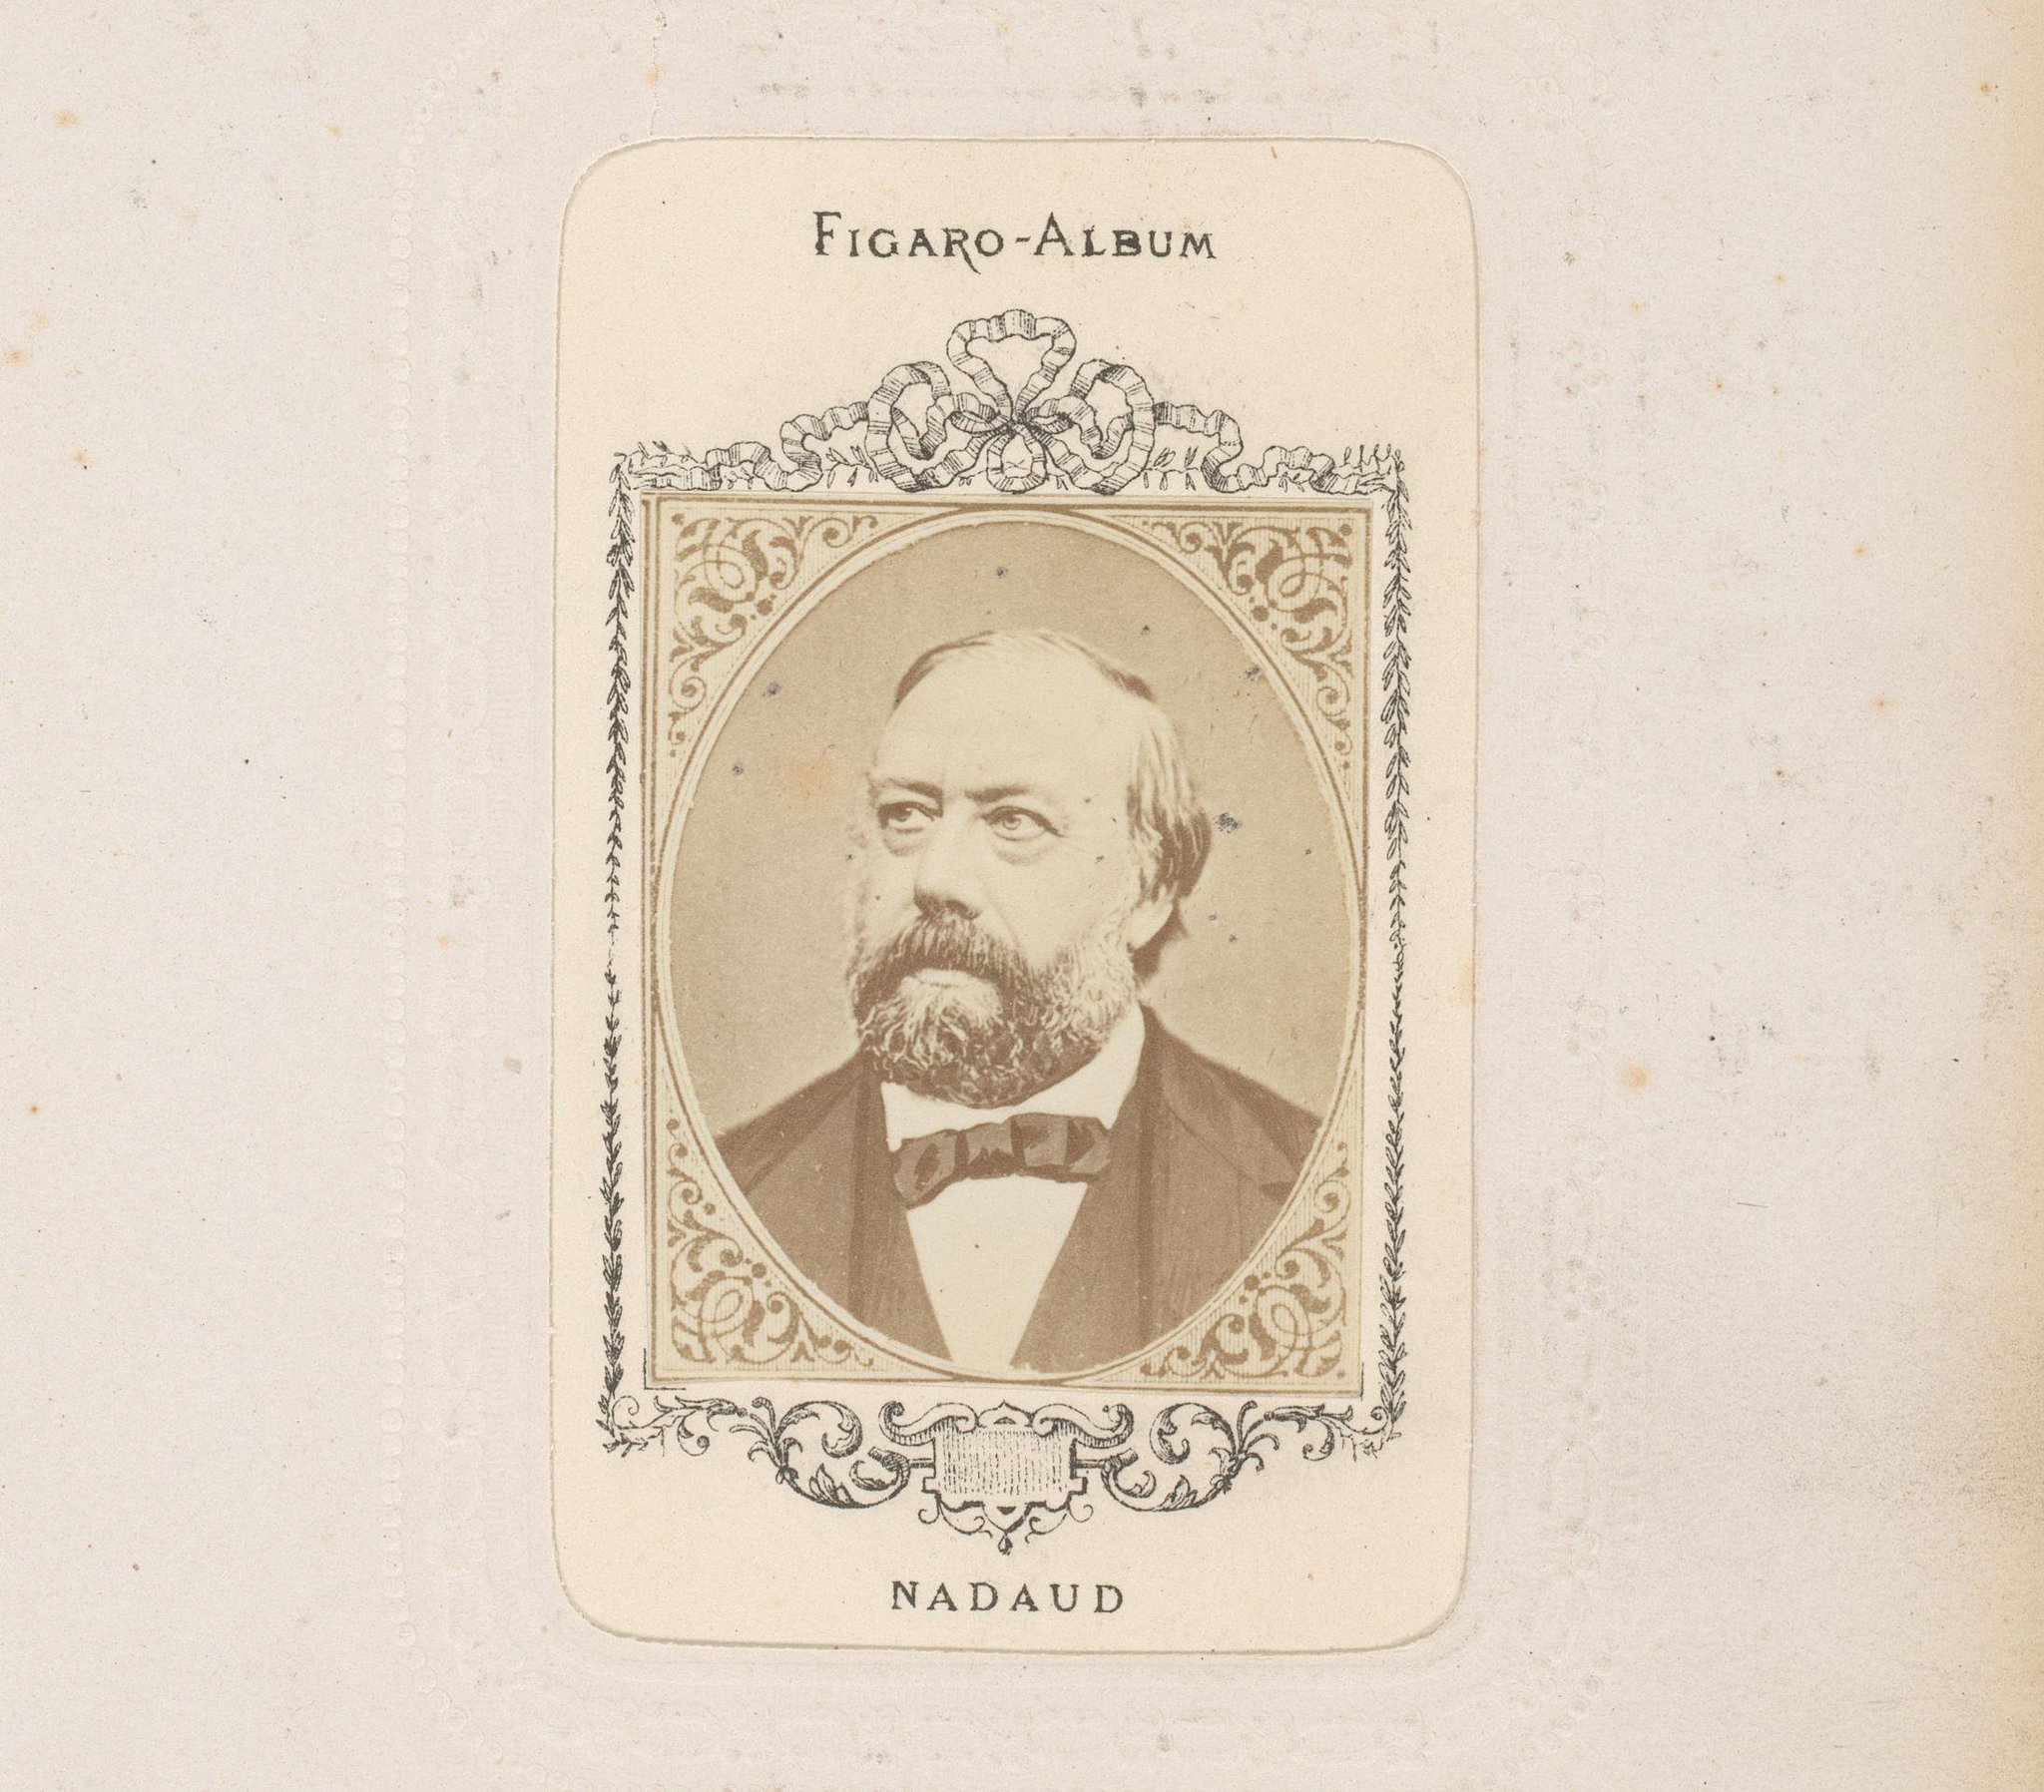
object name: album leaf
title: Fotoreproductie van een portret van Gustave Nadaud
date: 1860-1900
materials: cardboard, photographic support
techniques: albumen print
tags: male singer, historical persons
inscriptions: inscription: ‘Figaro-Album/ Naduad/ d'après Carjat Phot.’